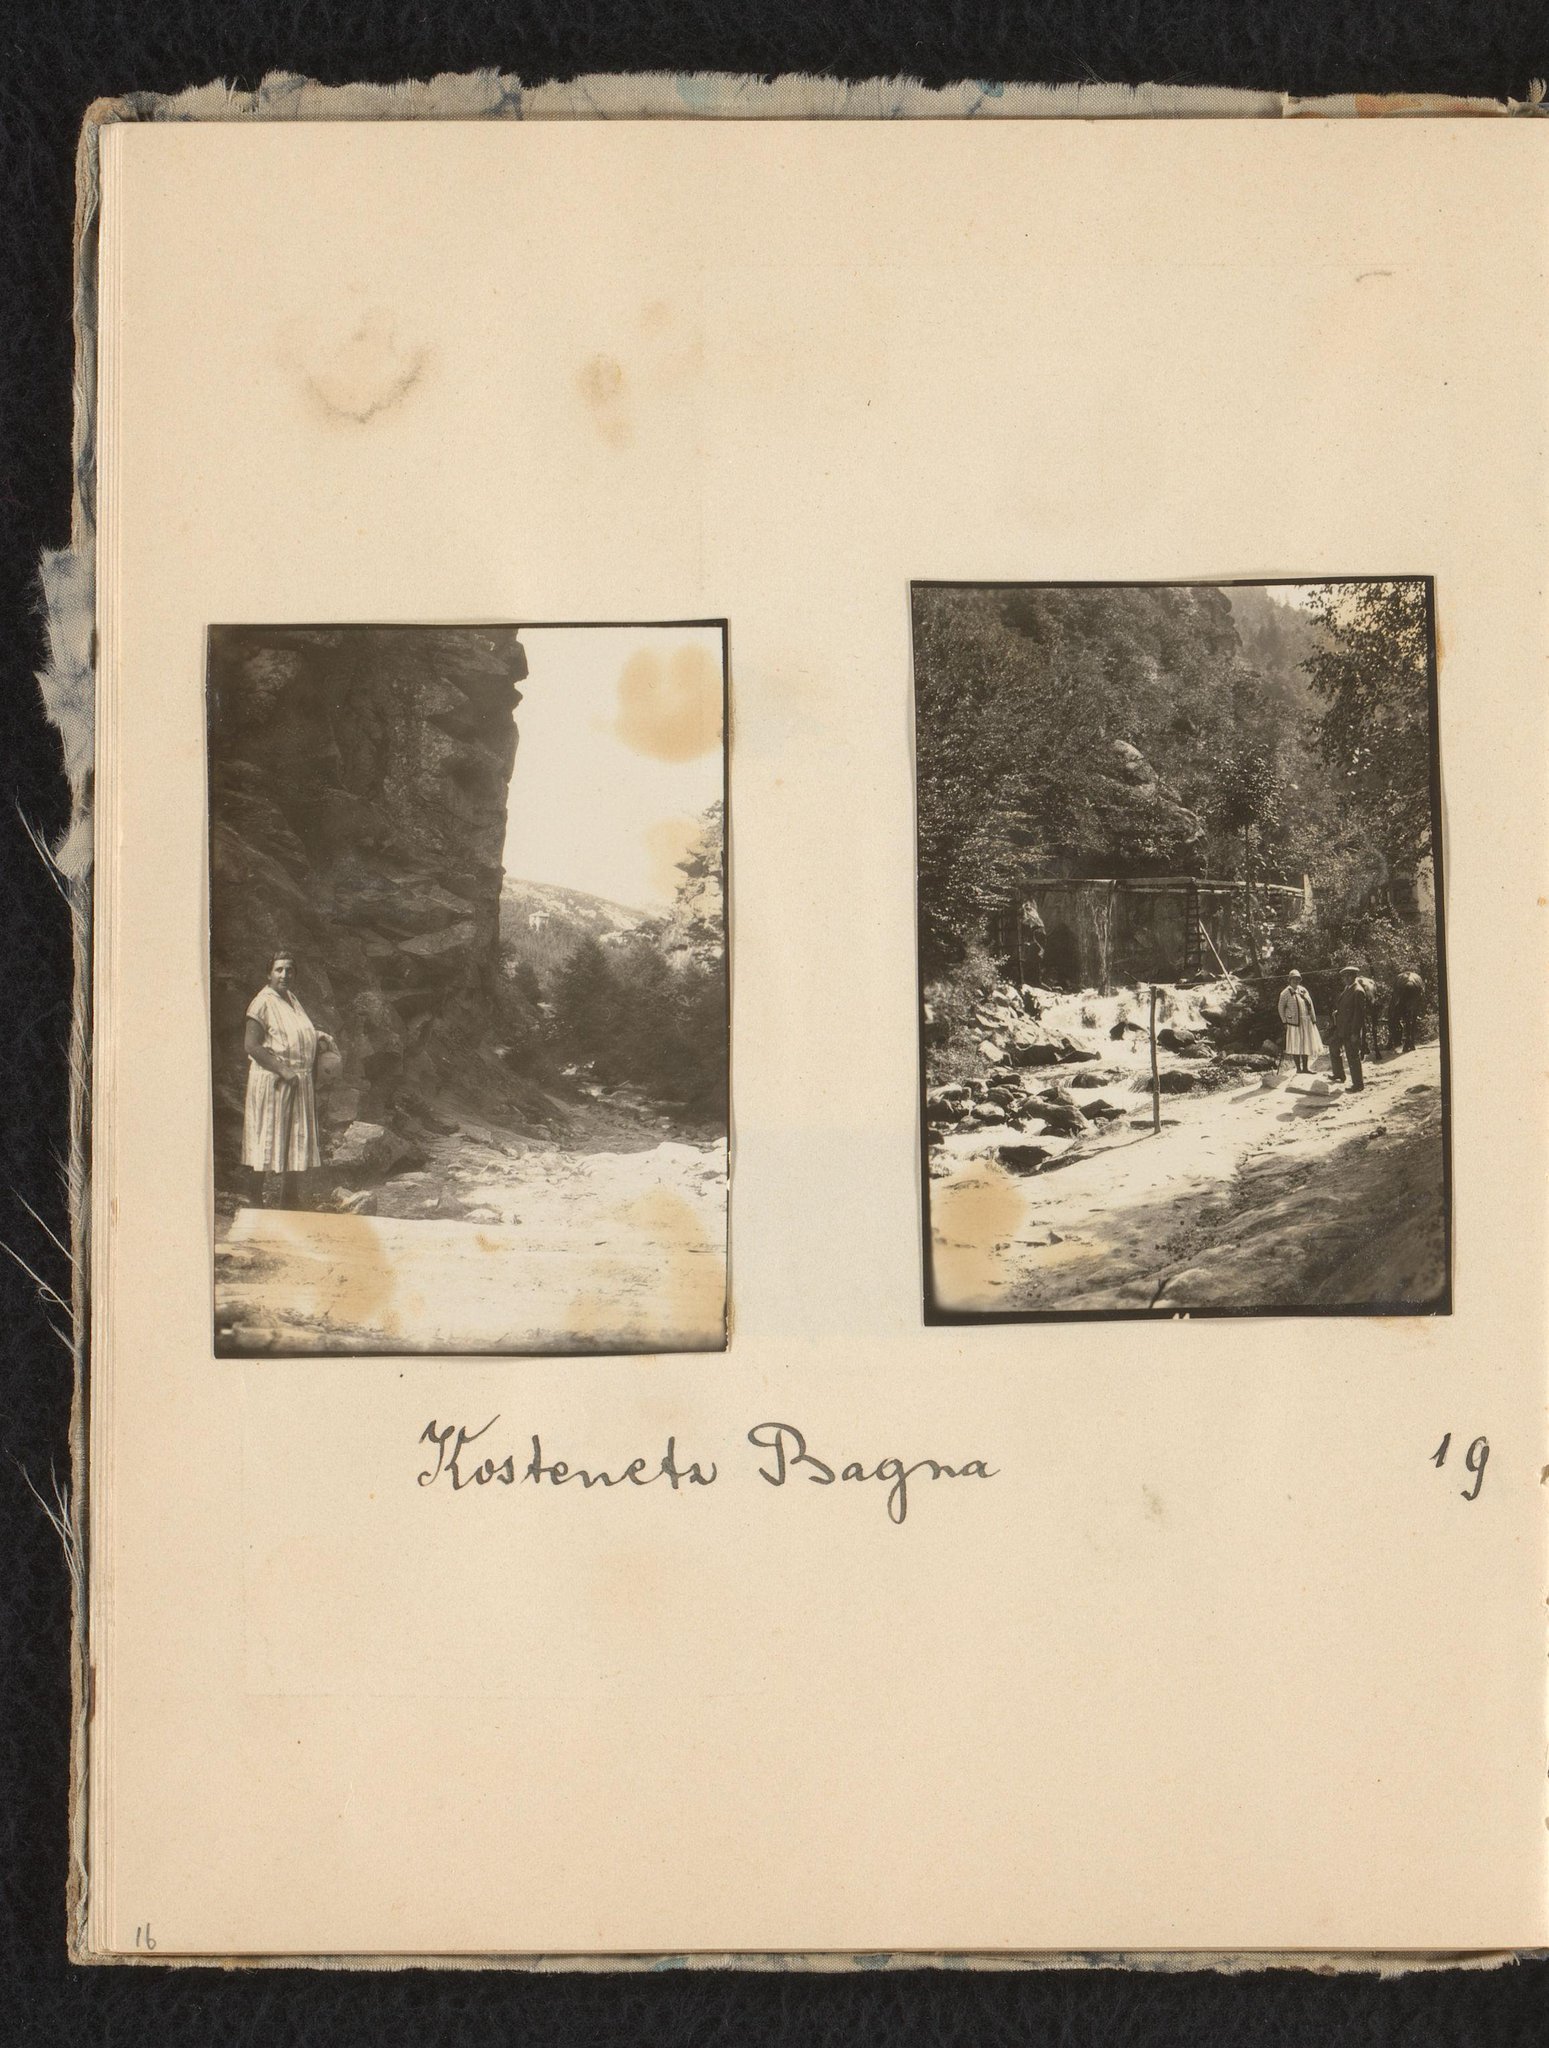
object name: photograph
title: Else Wachenheimer-Moos en haar echtgenoot Eugen Wachenheimer op rondreis in Kostenets (Bulgarije), 1926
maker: else wachenheimer-moos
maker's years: 1895-1944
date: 1926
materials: paper, photographic support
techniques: gelatin silver print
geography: bulgaria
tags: eugen wachenheimer, else wachenheimer-moos, the family travelling, on holiday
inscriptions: inscription: ‘Kostenetz Bagna 19[26]’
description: Blad bevat twee foto's van Else Wachenheimer-Moos (links) en Eugen Wachenheimer (rechts). Onderdeel van het fotoalbum van de reizen die Eugen en Else Wachenheimer jaarlijks maakten rondom de viering van hun huwelijksdag en verloving.